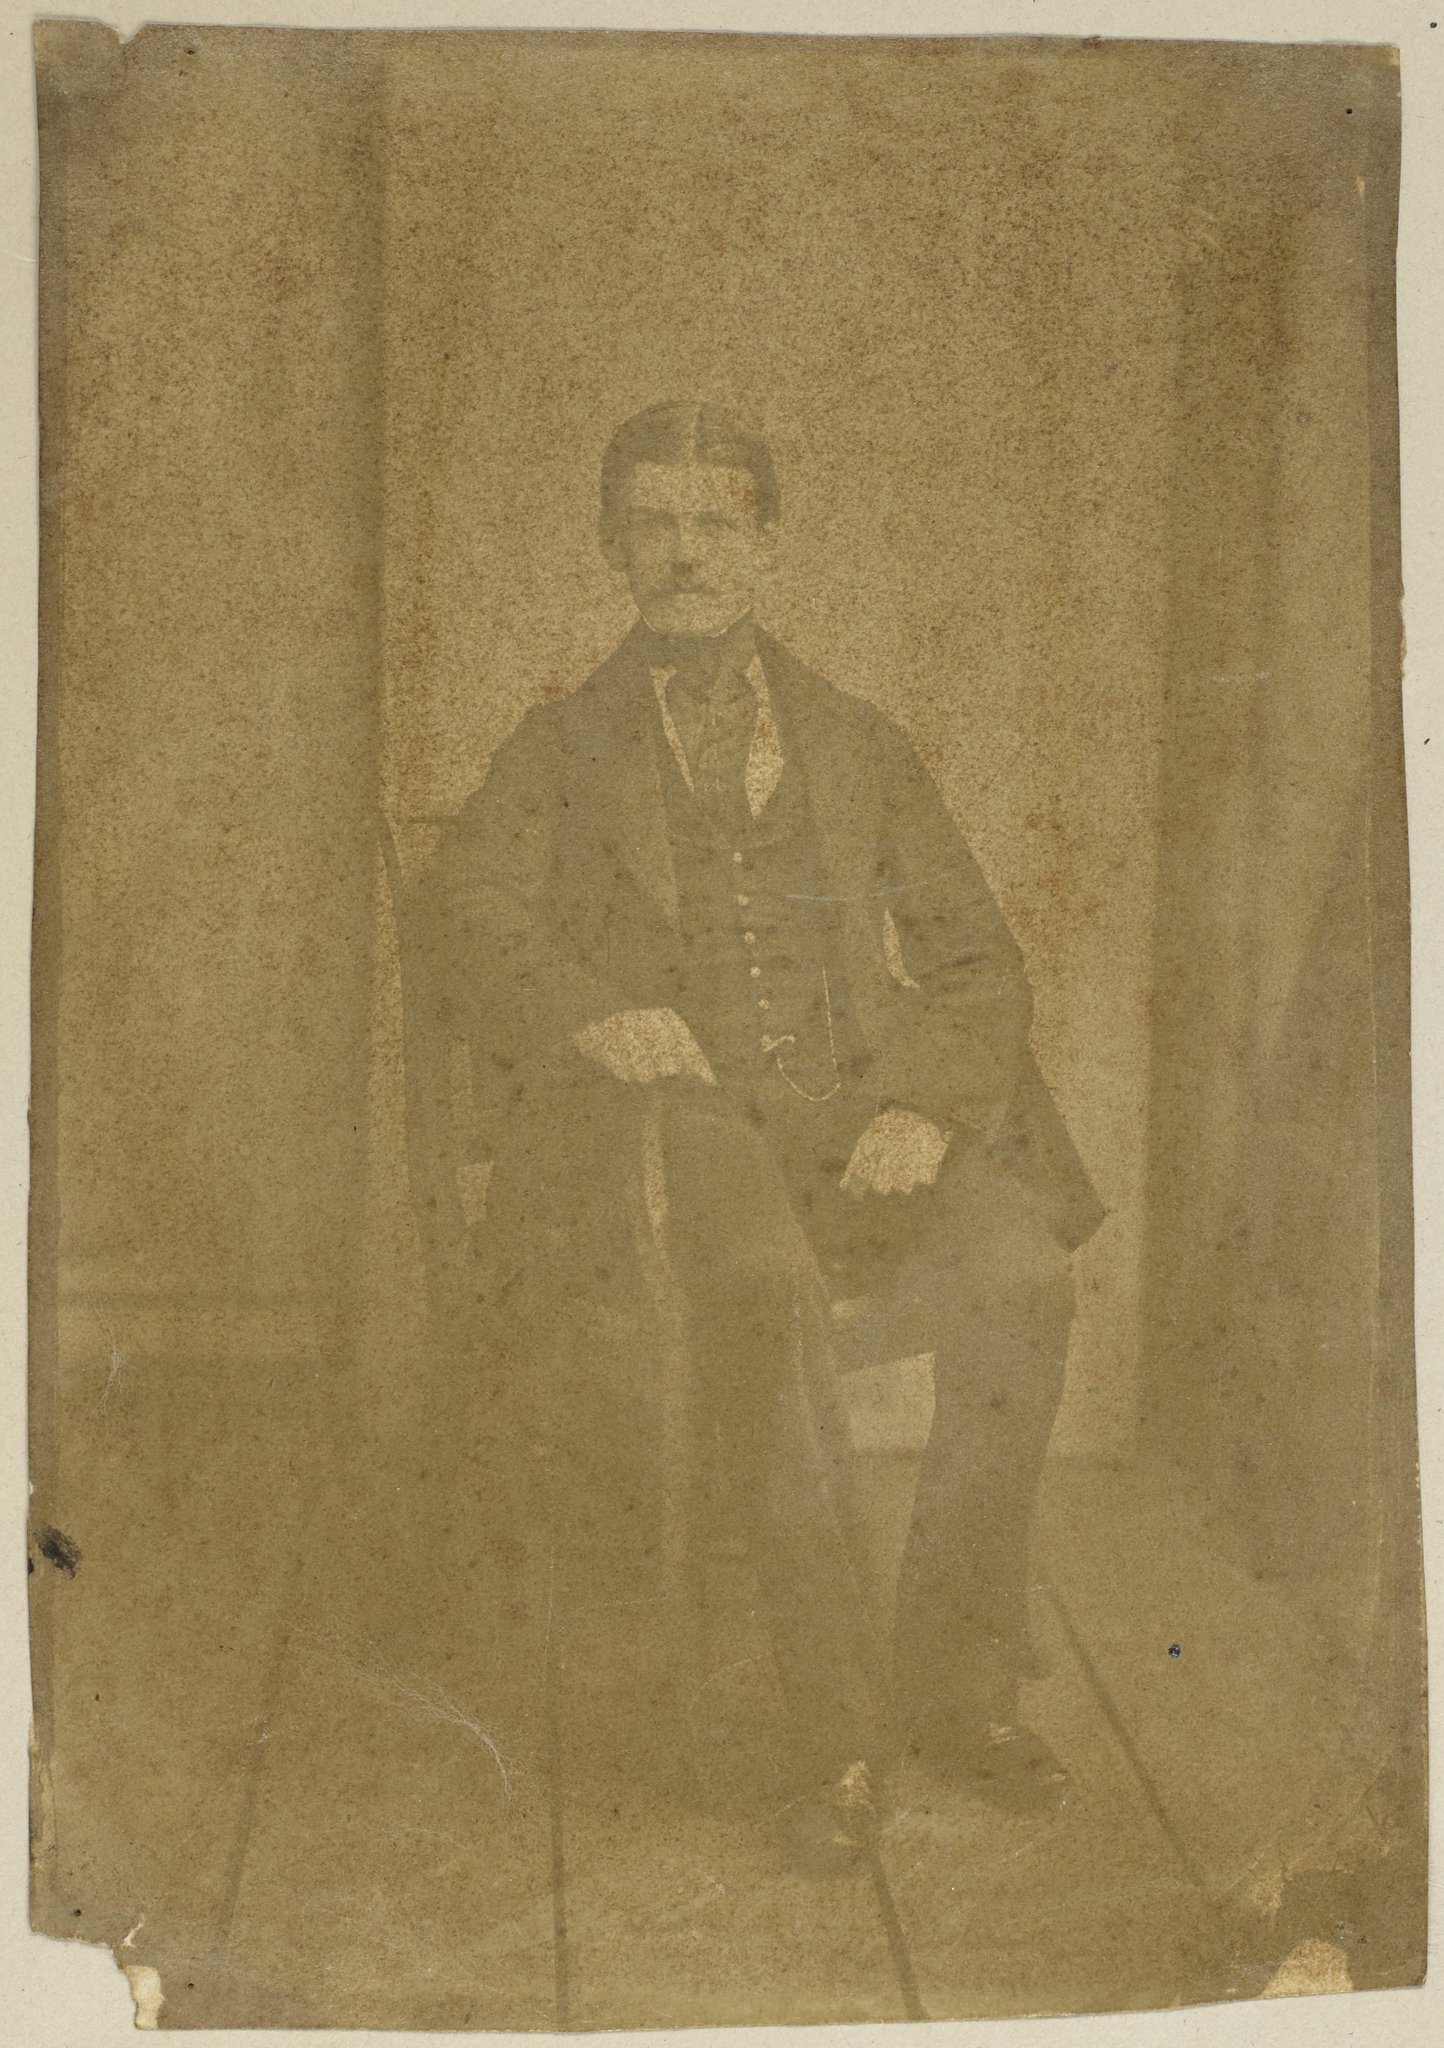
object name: photograph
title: Portret van een jonge man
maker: eduard isaac asser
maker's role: amateurfotograaf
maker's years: 1809-1894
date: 1853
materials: cardboard, paper, photographic support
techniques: salted paper print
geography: amsterdam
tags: historical persons, netherlands